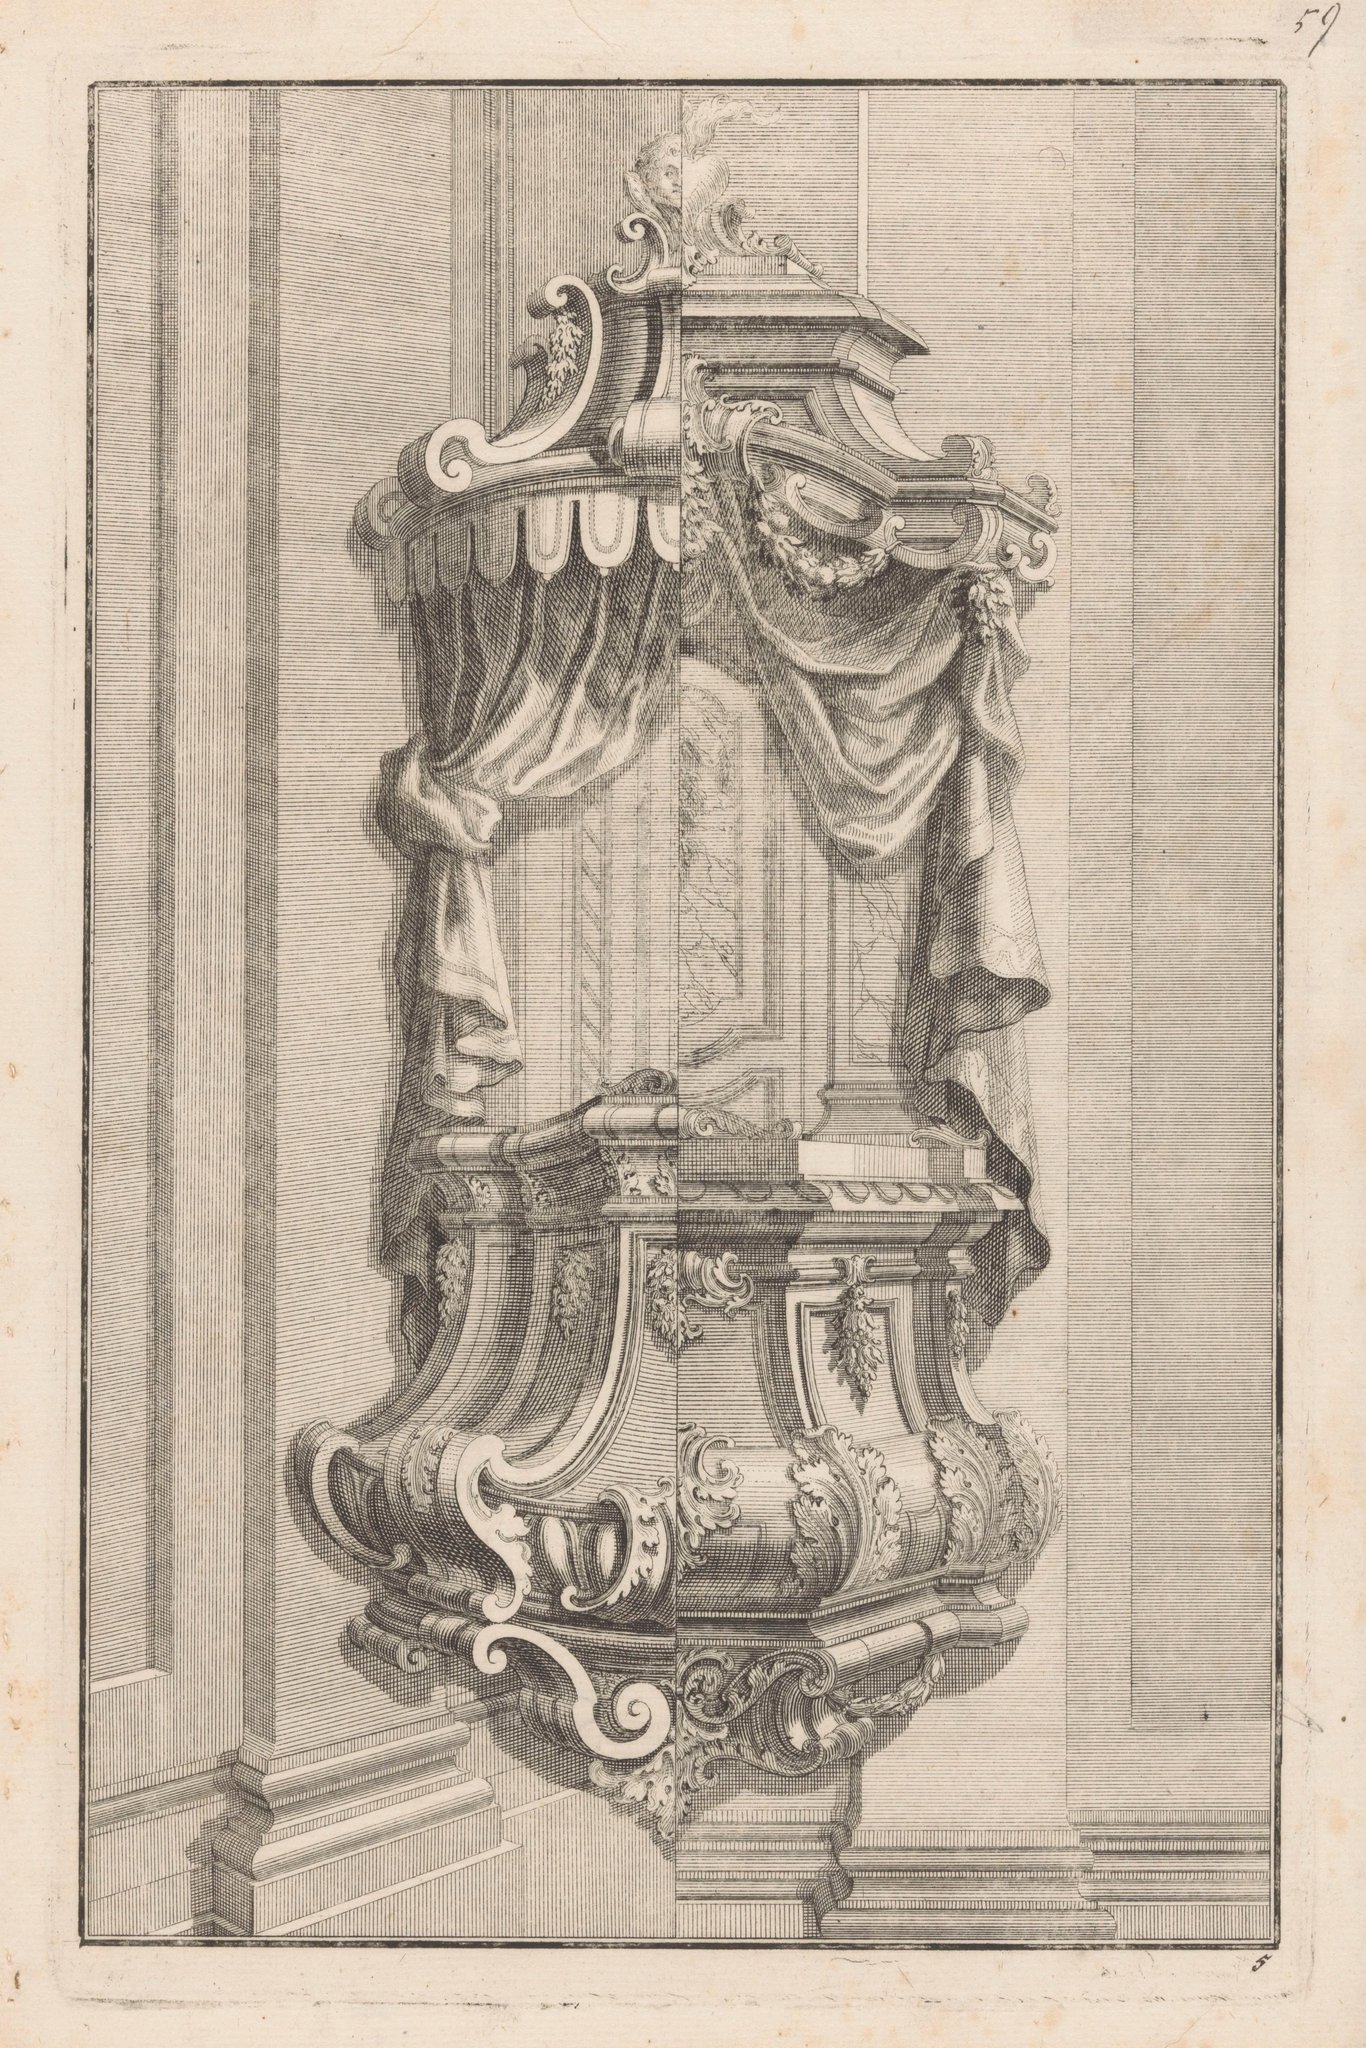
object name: ornament print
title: Neu Faconirte Orgel-verkleidungen und unterschiedliche Wand Cantzeln (...)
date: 1699-1726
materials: paper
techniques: engraving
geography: nuremberg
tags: rocaille ornament, pulpit, ambo, chancel, hangings and drapery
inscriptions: collector's mark: Lugt 2228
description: Prent uit: Schübler, Johann Jacob. Neu Faconirte Orgel-verkleidungen und unterschiedliche Wand Cantzeln (...). [Neurenberg]: Weigel, Johann Christoph, [voor 1726].